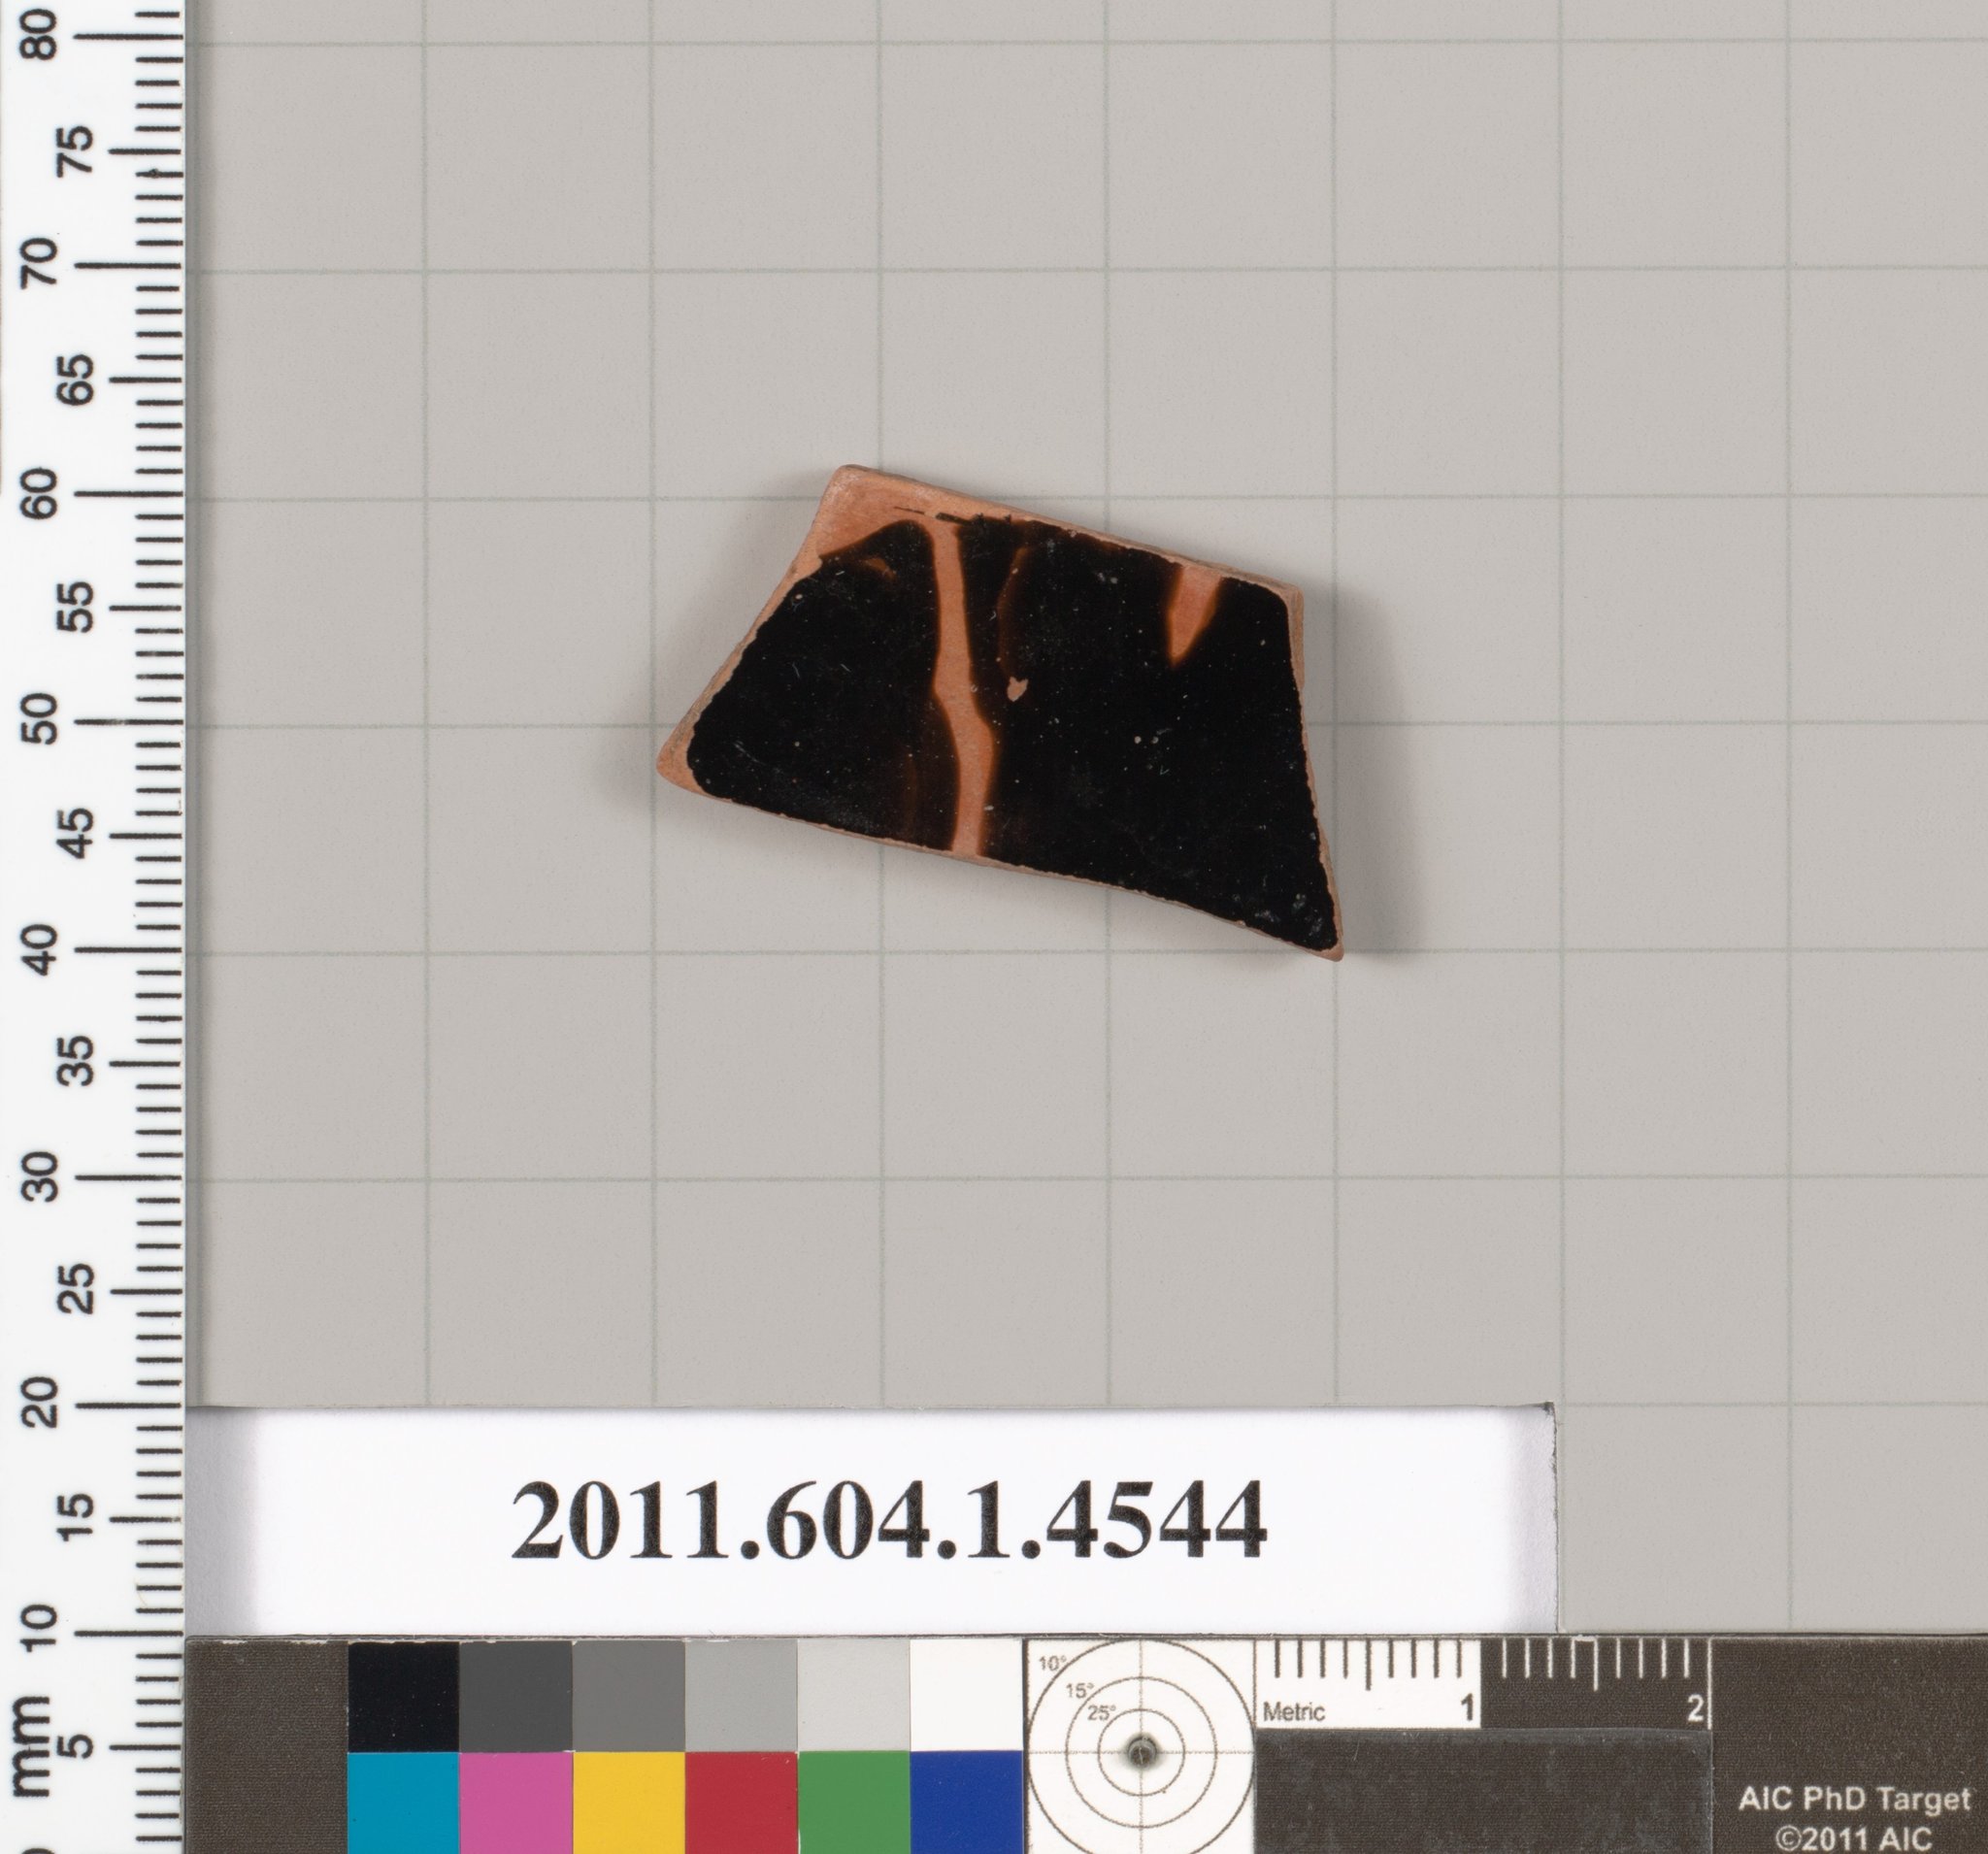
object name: kylix fragment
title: Terracotta fragment of a kylix (drinking cup)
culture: greek, attic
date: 475-451 BCE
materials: terracotta